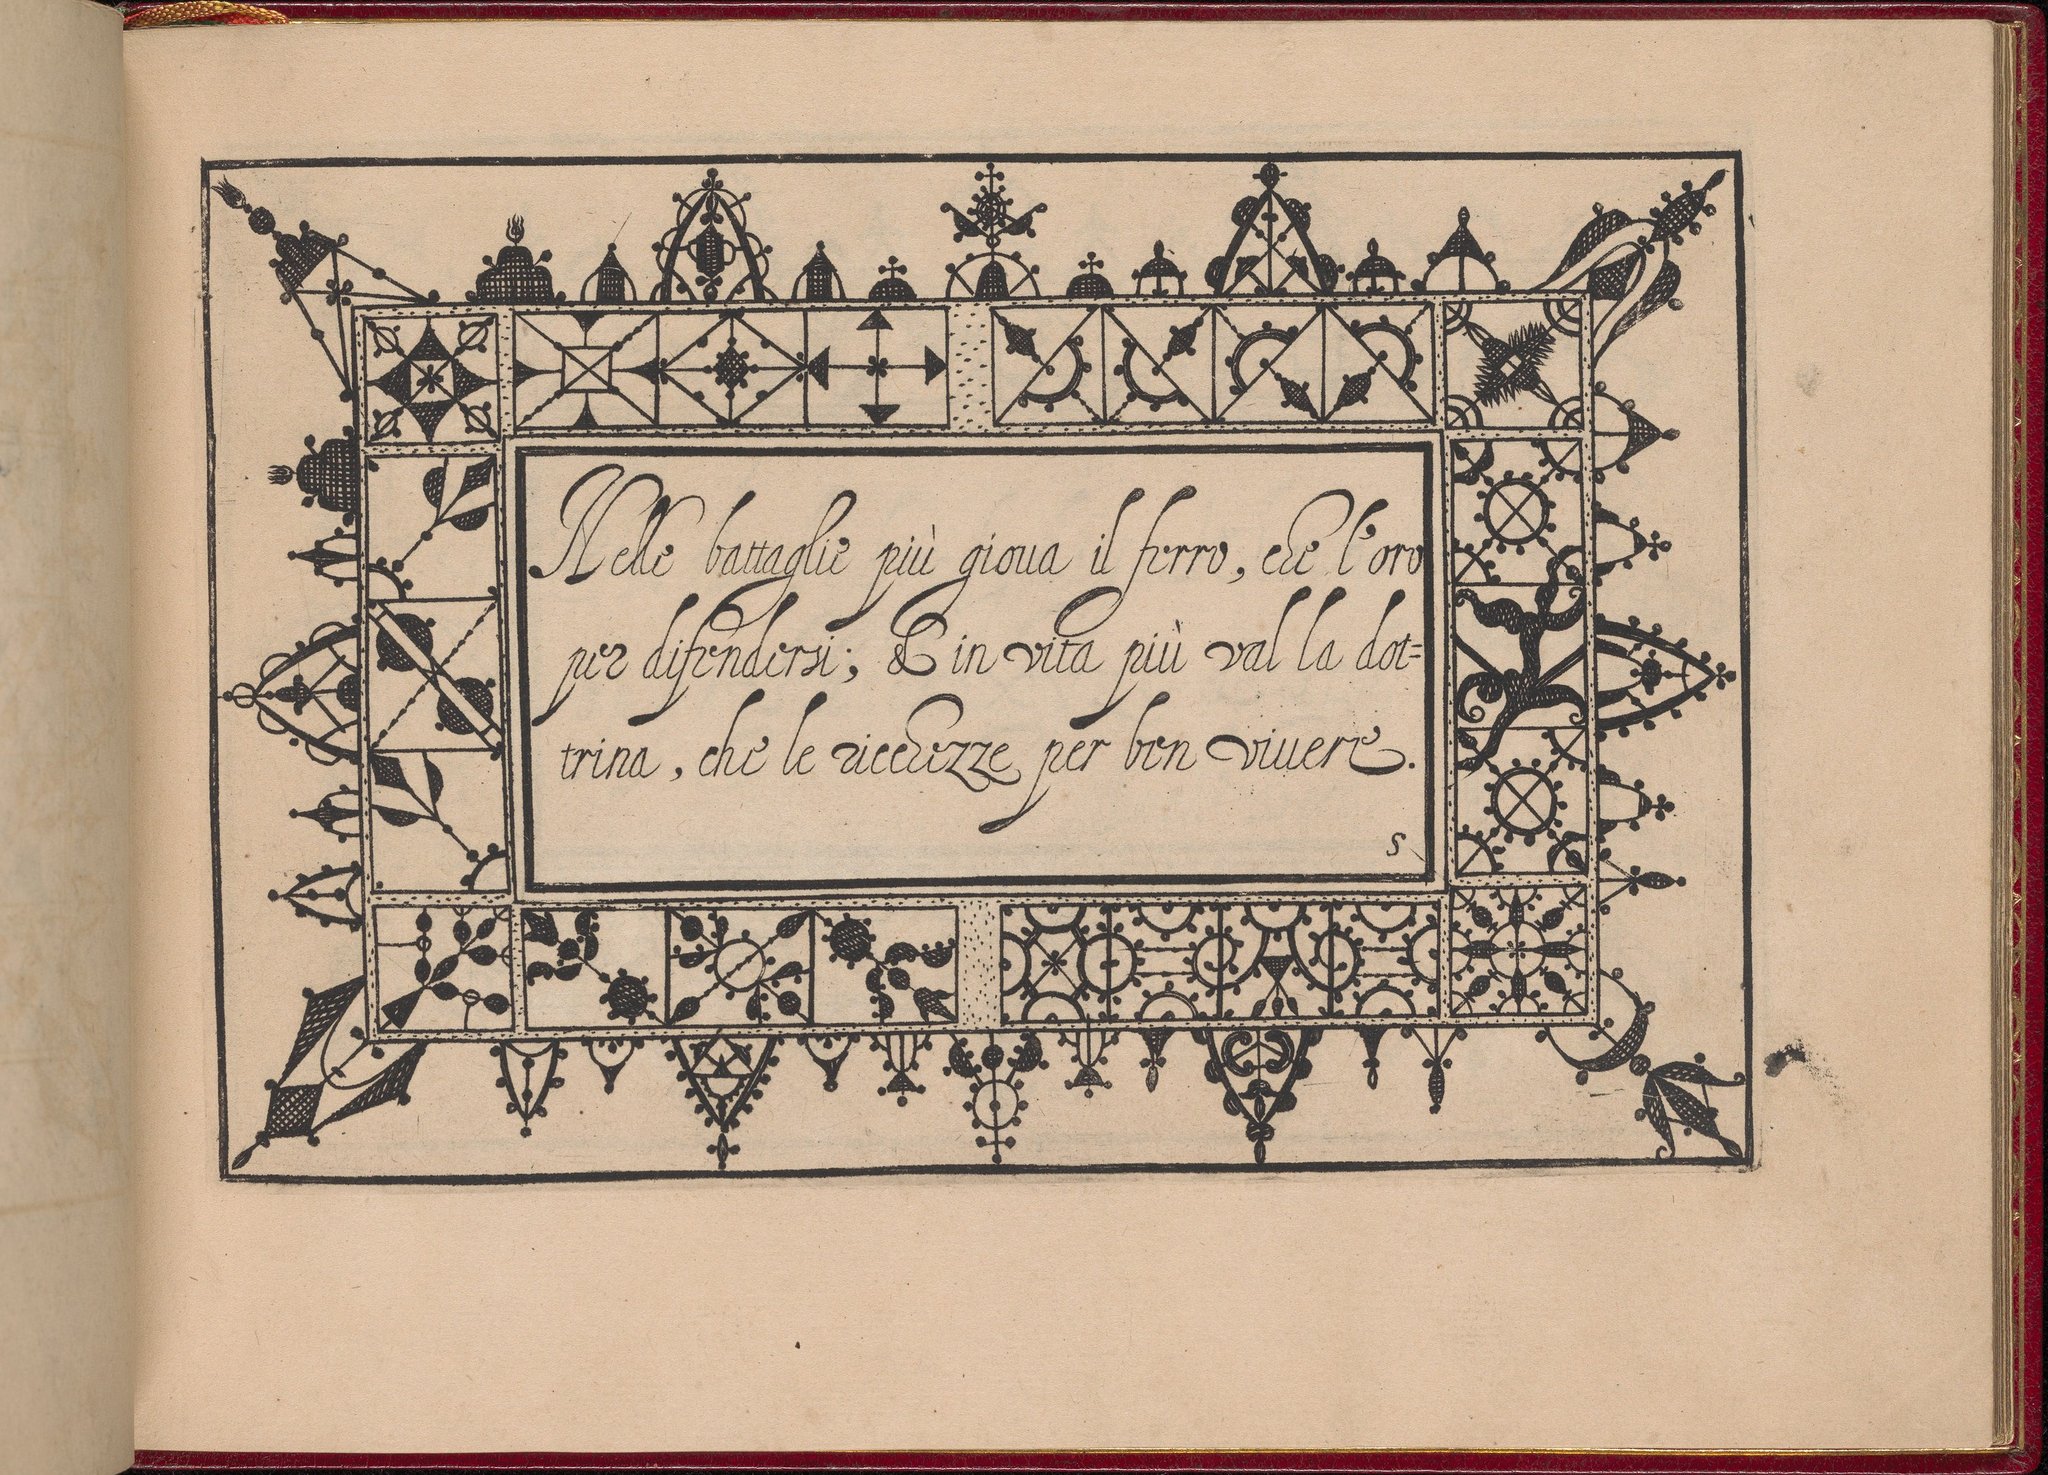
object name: book print ornament architecture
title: Ghirlanda: Di sei vaghi fiori scielti da piu famosi Giardini d'Italia, page 13 (recto)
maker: pietro paulo tozzi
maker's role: designer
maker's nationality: italian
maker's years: 1593-1628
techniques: drawing, etching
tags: ornament